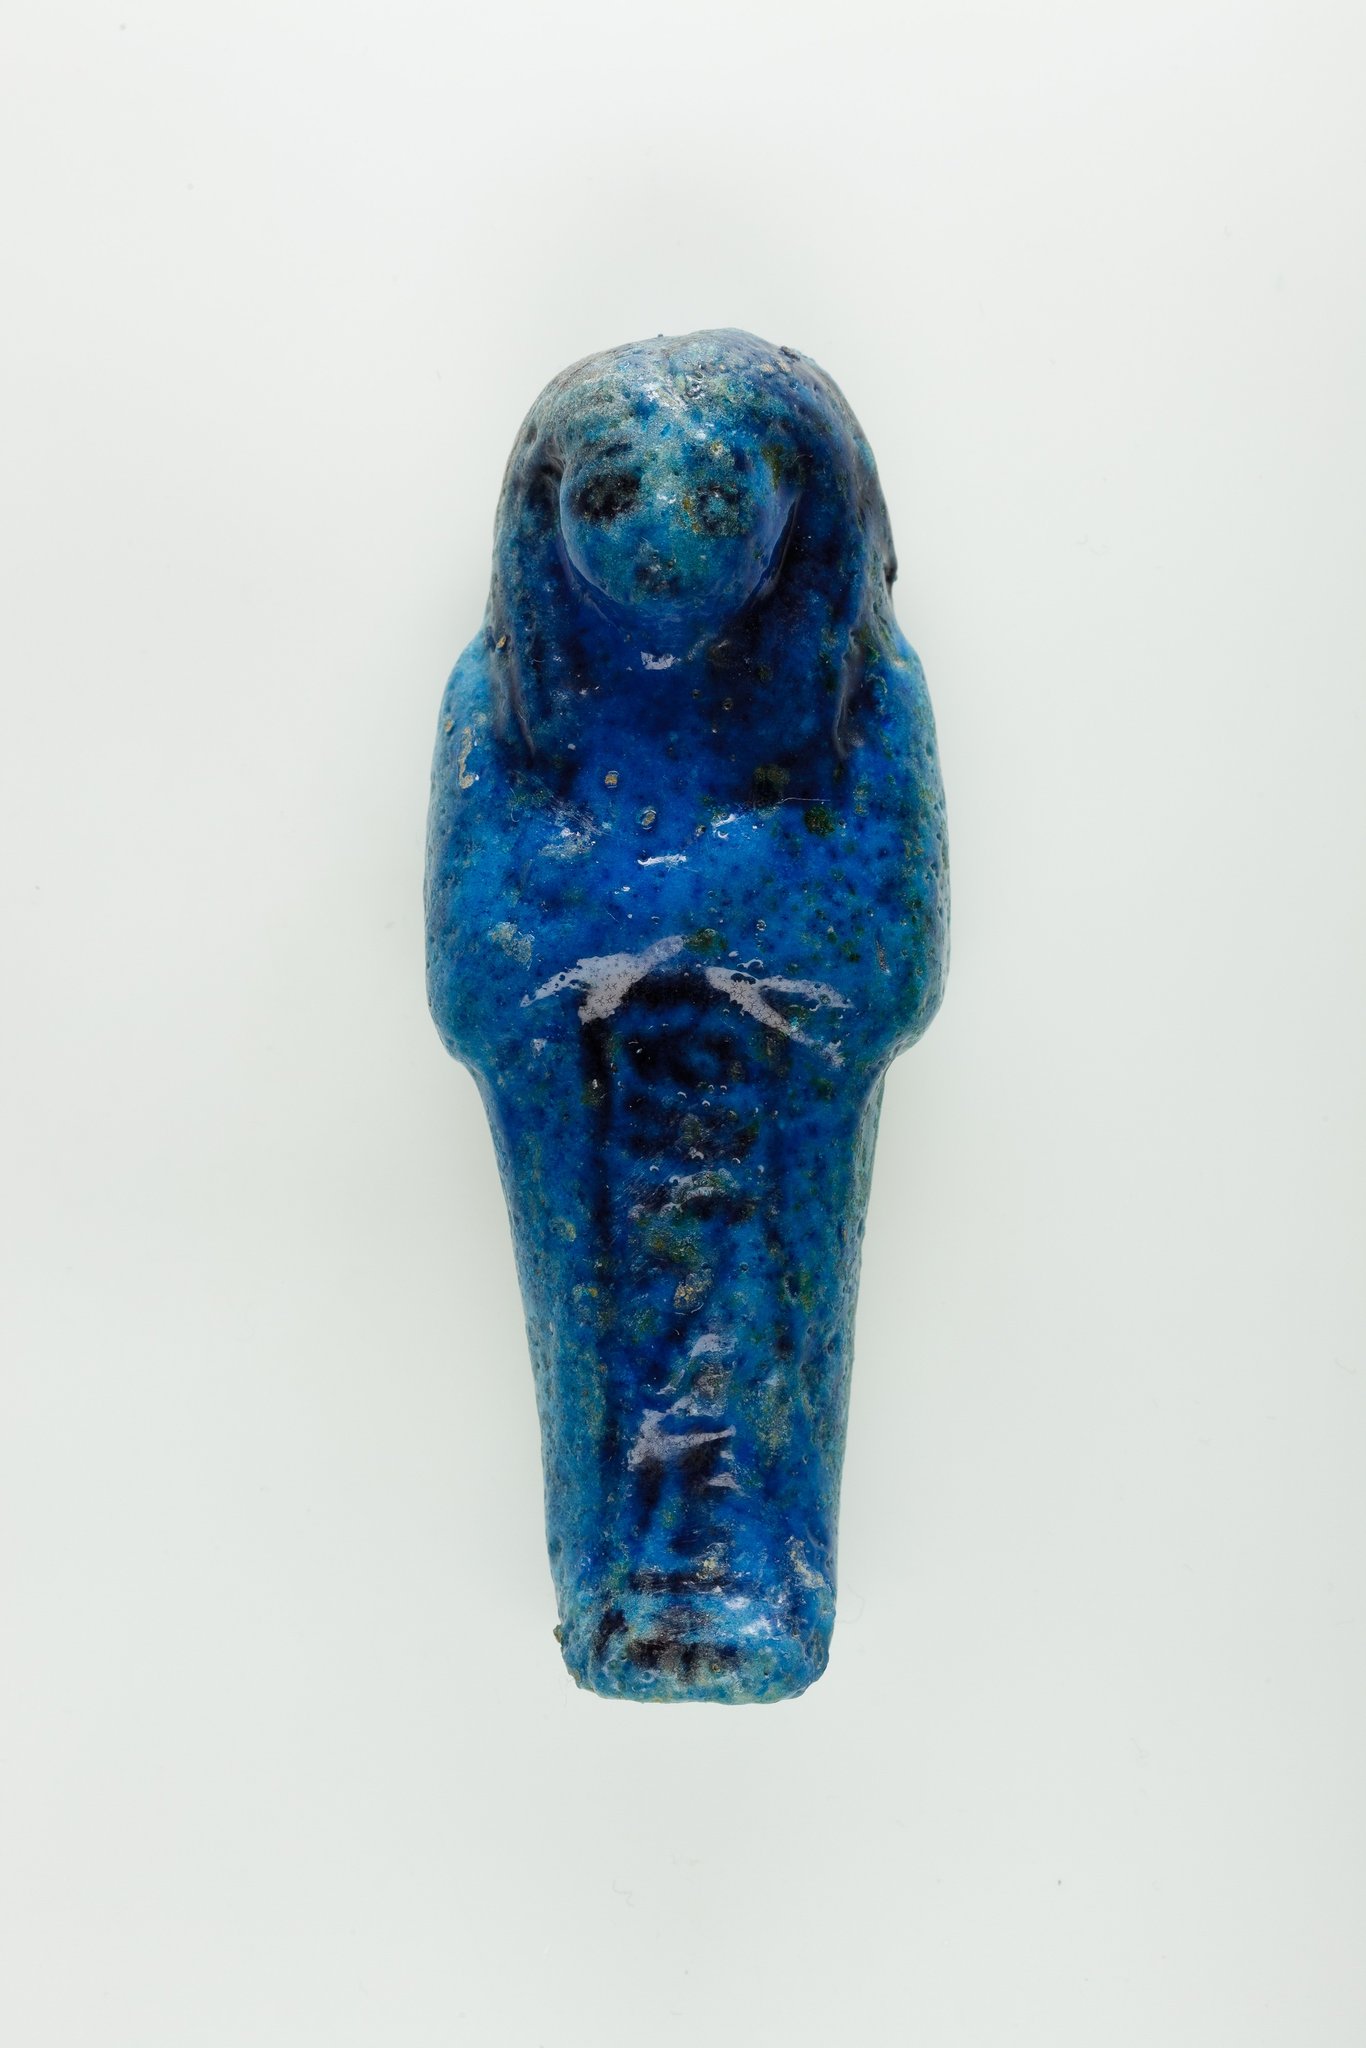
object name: shabti, worker, nauny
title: Worker Shabti of Nauny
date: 1050 BCE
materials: faience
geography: egypt